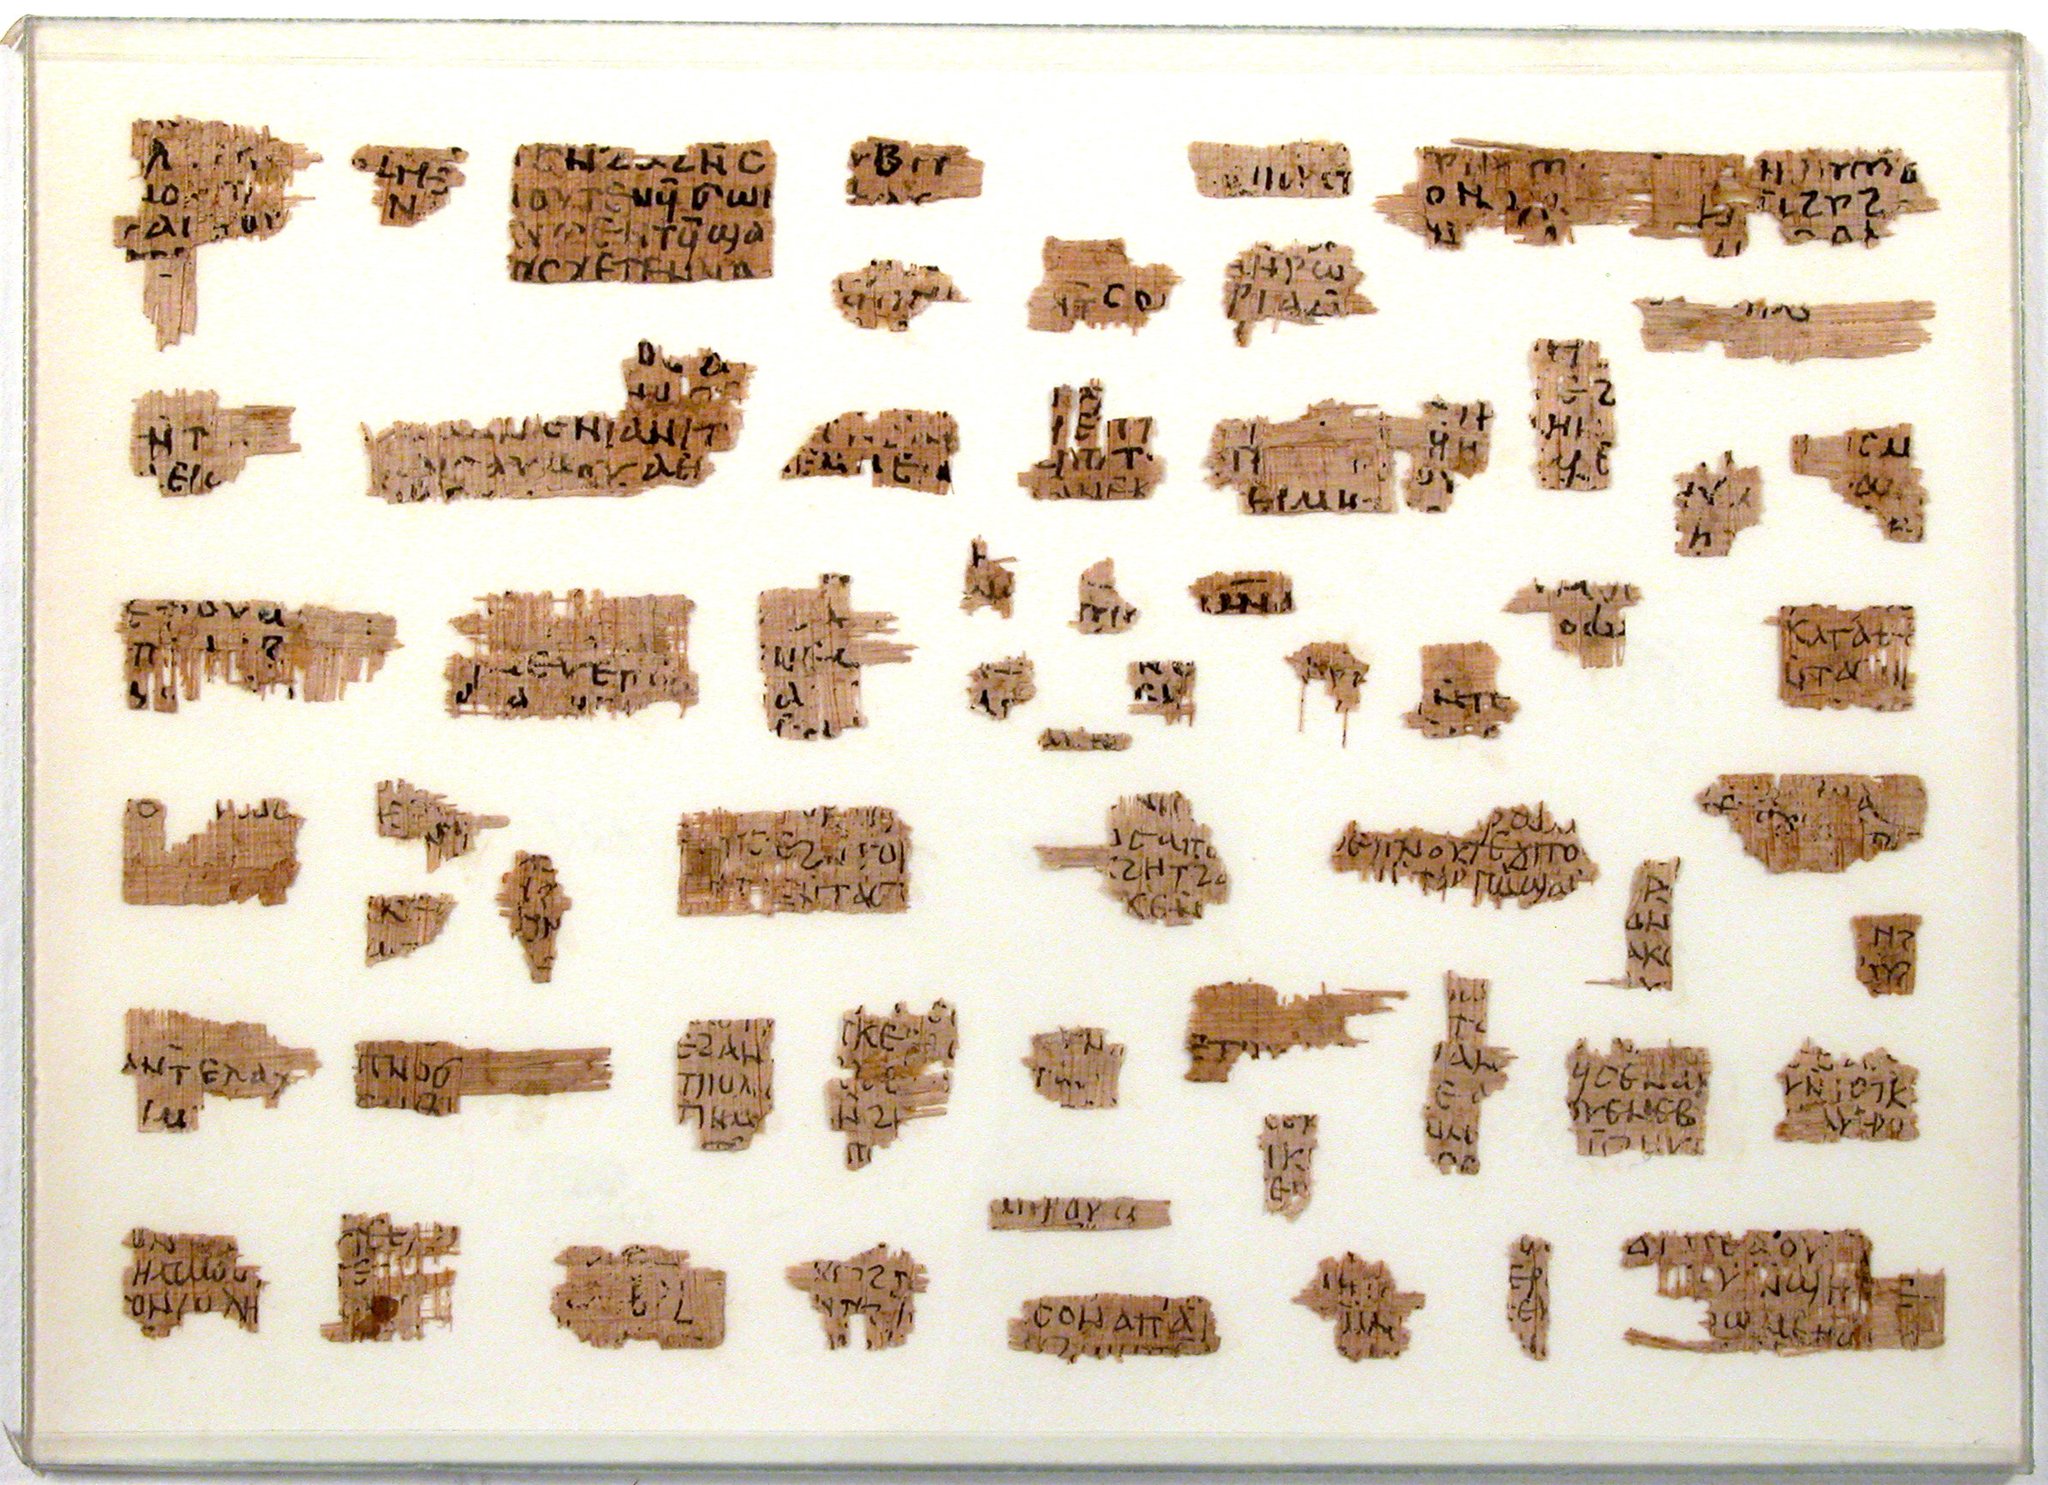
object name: fragment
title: Papyrus Fragments of a Letter from Joseph to Epiphanius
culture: coptic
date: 580-640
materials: ink, papyrus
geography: egypt